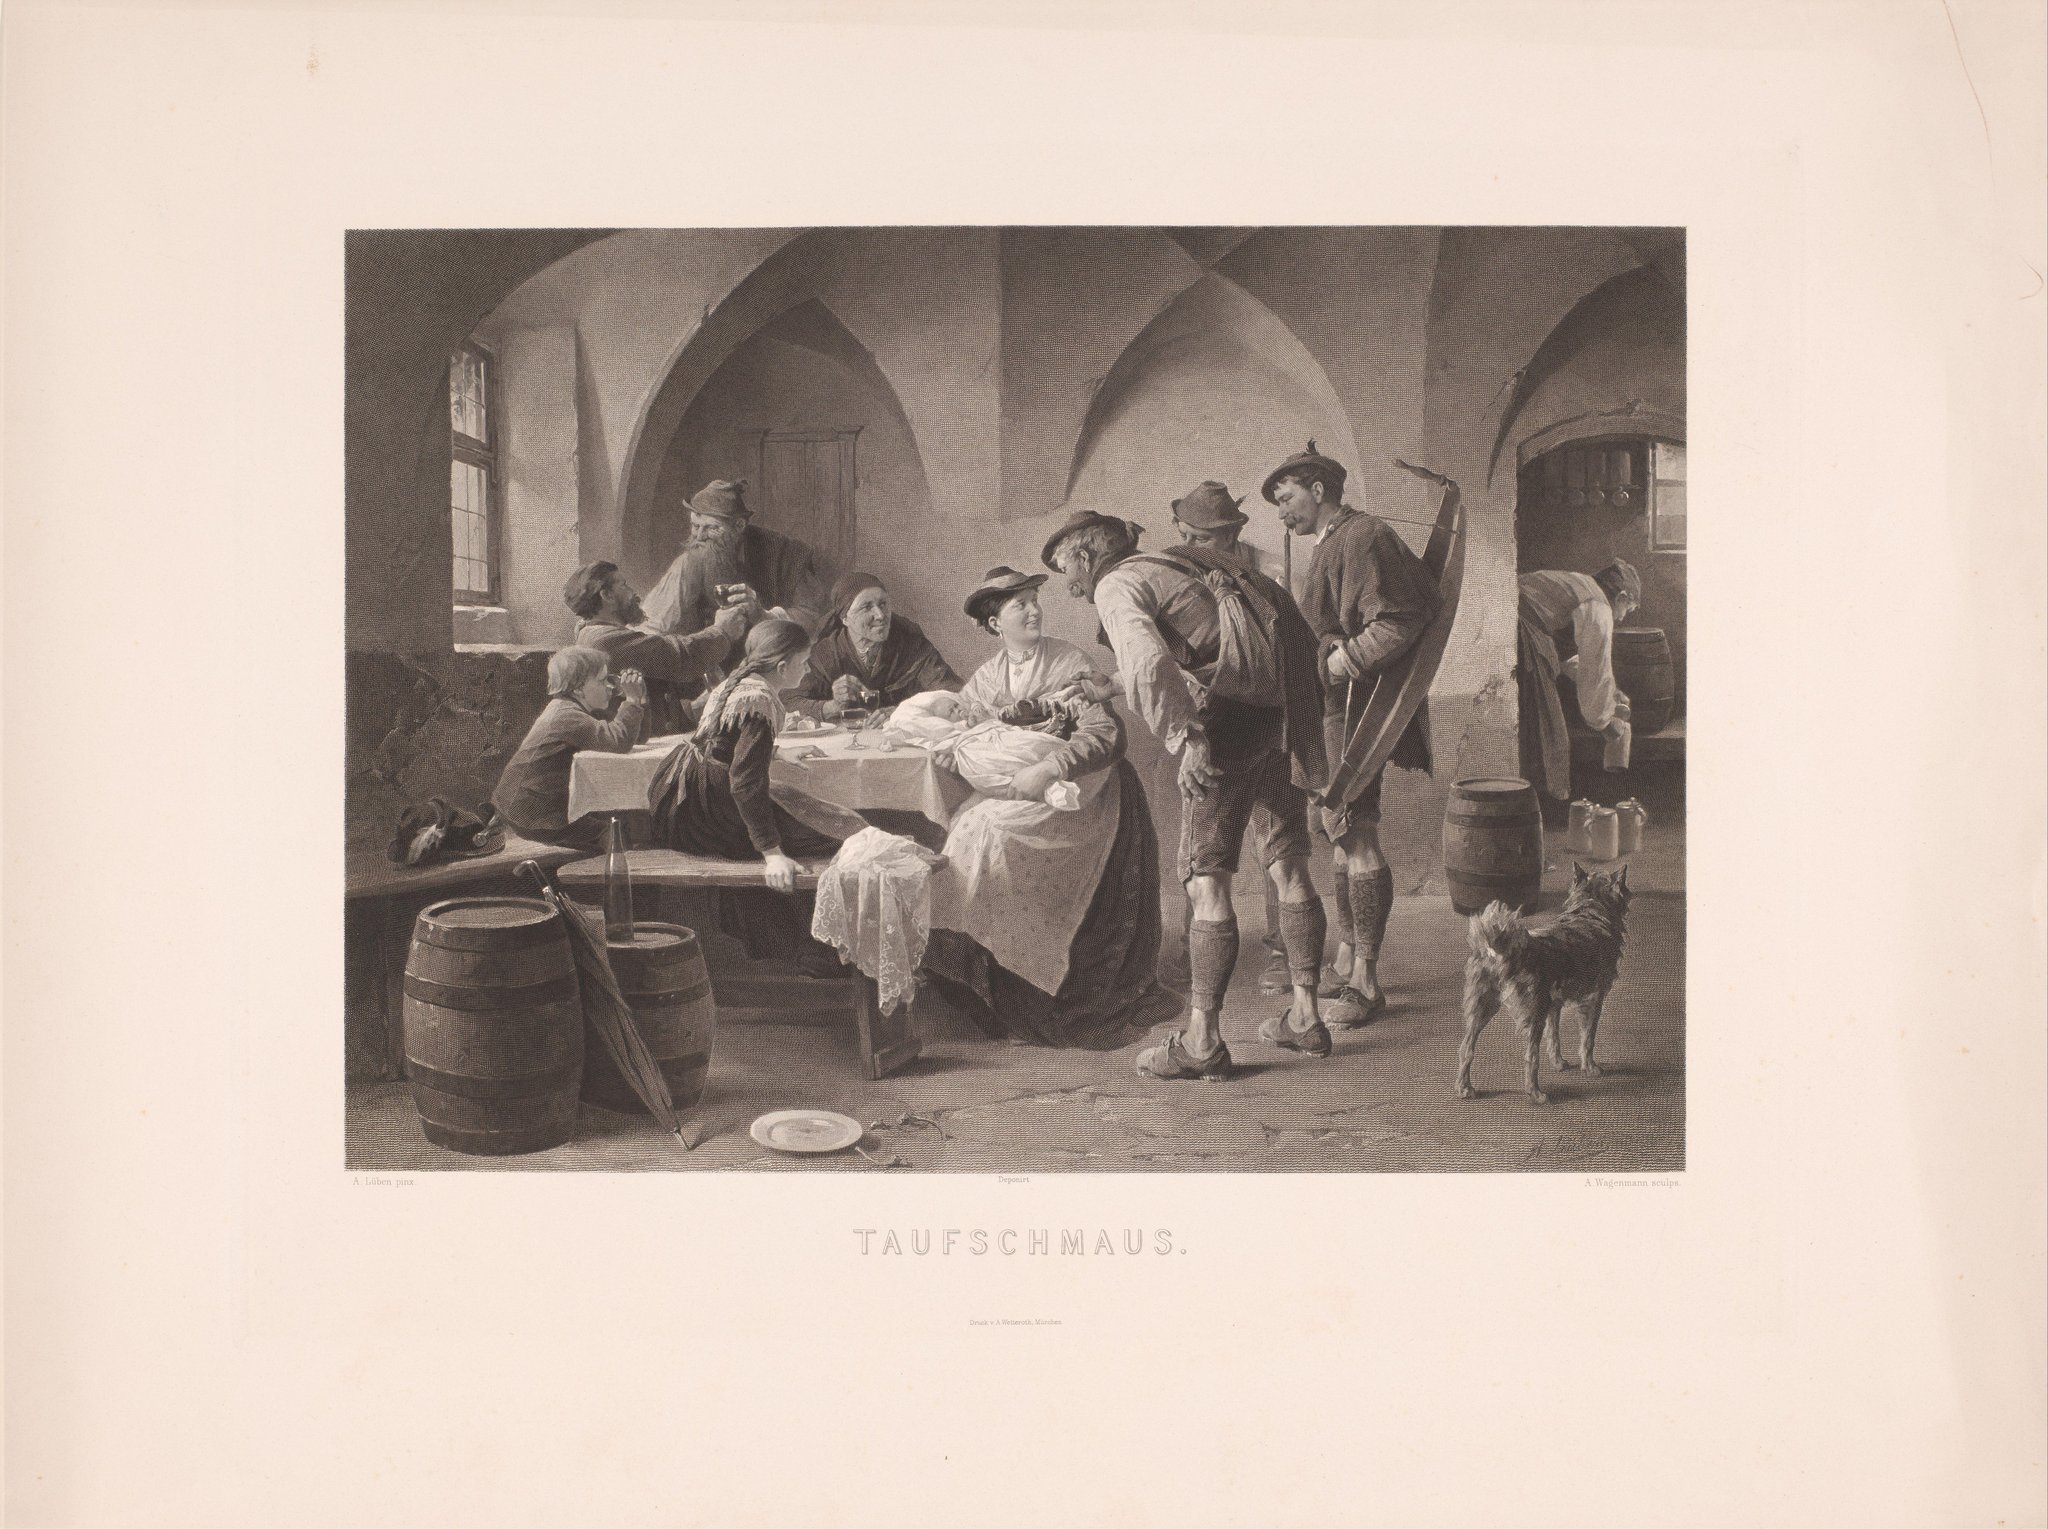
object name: print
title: Taufschmaus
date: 1849-1904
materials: paper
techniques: etching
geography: munich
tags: celebration meal, feast, banquet, baptism ~ protestant service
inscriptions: collector's mark: Lugt 2228